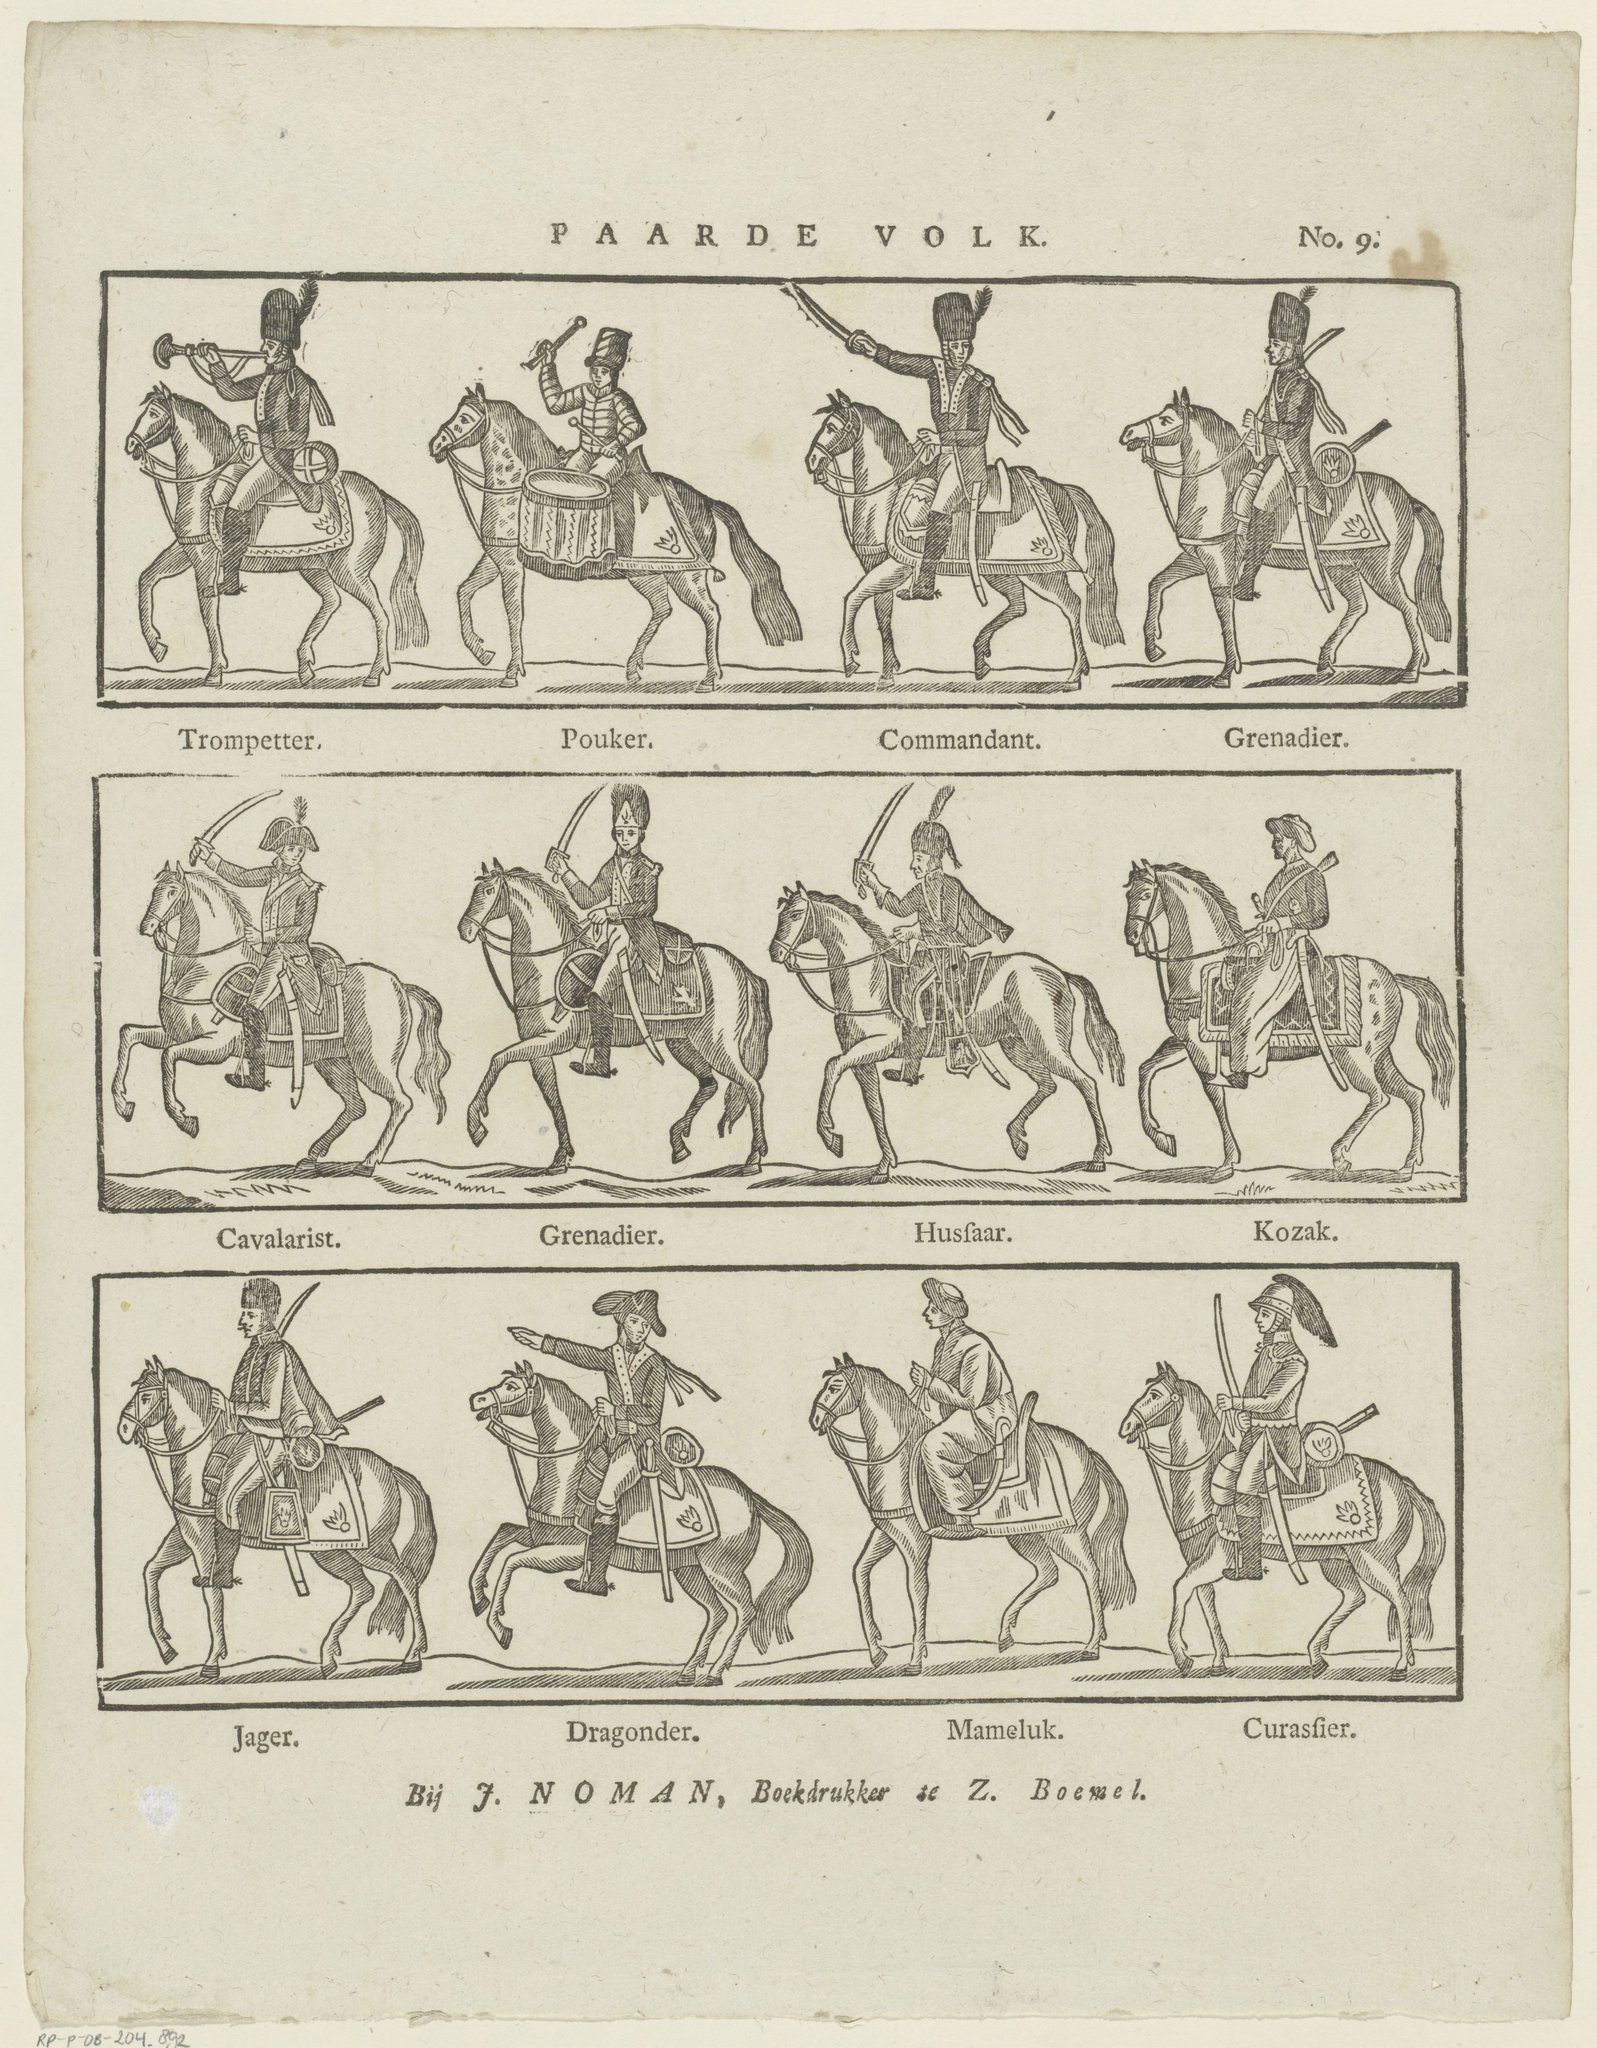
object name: popular print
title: Paarde volk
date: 1806-1830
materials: paper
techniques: letterpress printing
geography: netherlands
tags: warfare; military affairs (+ cavalry, horsemen), the soldier; the soldier's life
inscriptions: collector's mark: Lugt 2760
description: Blad met 3 voorstellingen van telkens vier militairen te paard. Onder elke afbeelding een onderschrift. Genummerd rechtsboven: No. 9.